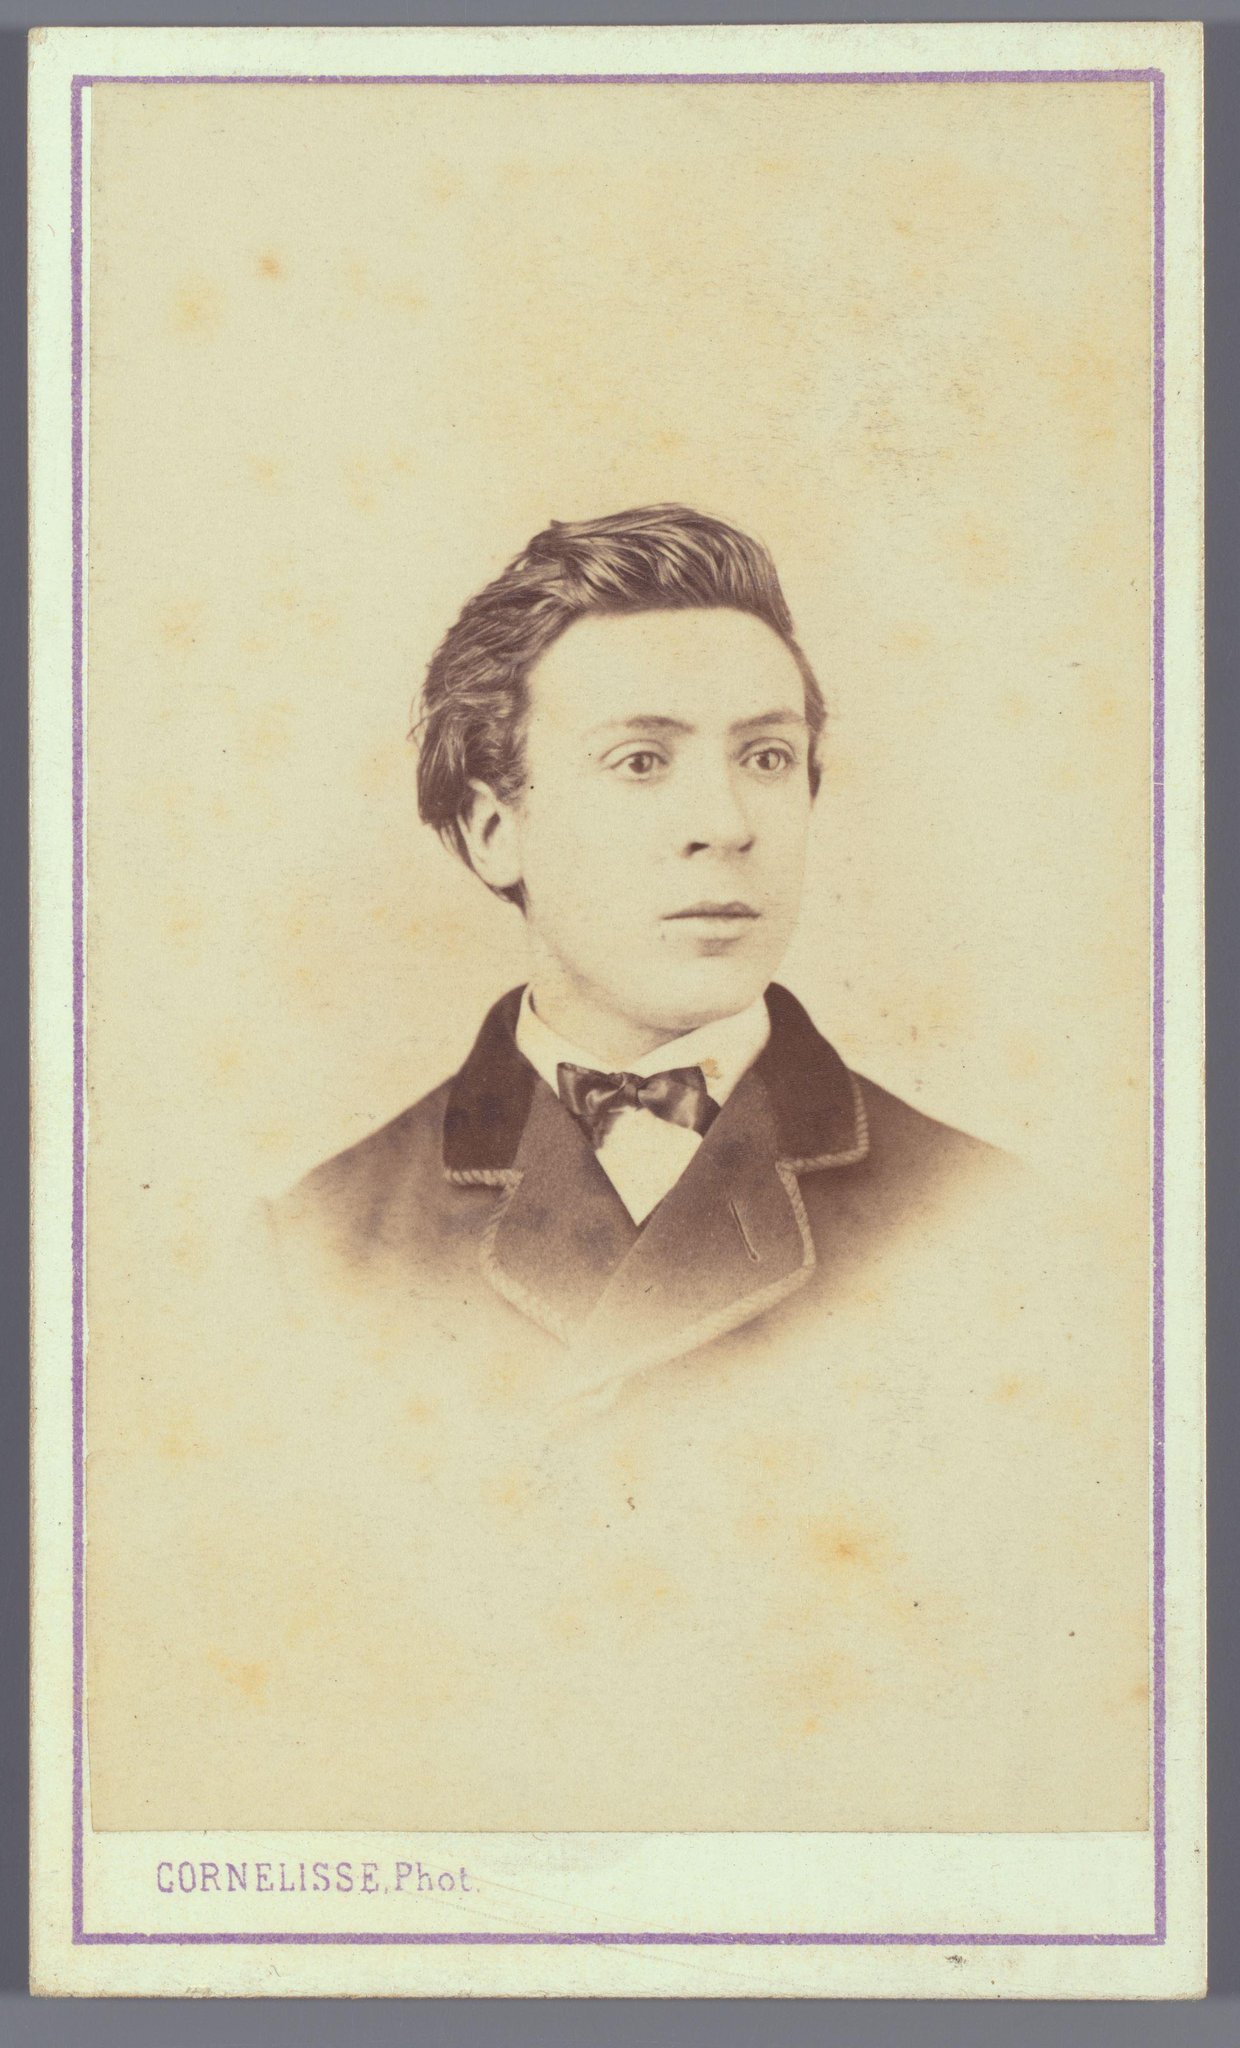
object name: photograph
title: Portret van een onbekende jongeman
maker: e. cornelisse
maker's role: fotograaf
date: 1863-1875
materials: cardboard, paper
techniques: albumen print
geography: rotterdam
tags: youth, adolescent, anonymous historical person portrayed, rotterdam, brussels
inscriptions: inscription: ‘Cornelisse, Phot.’, inscription: ‘Cornelisse/ Bruxelles, Rue de l'Ecuyer, 38./ Rotterdam, Wagestraat/ English spoken.’, inscription: ‘2€/ 72 Colans’